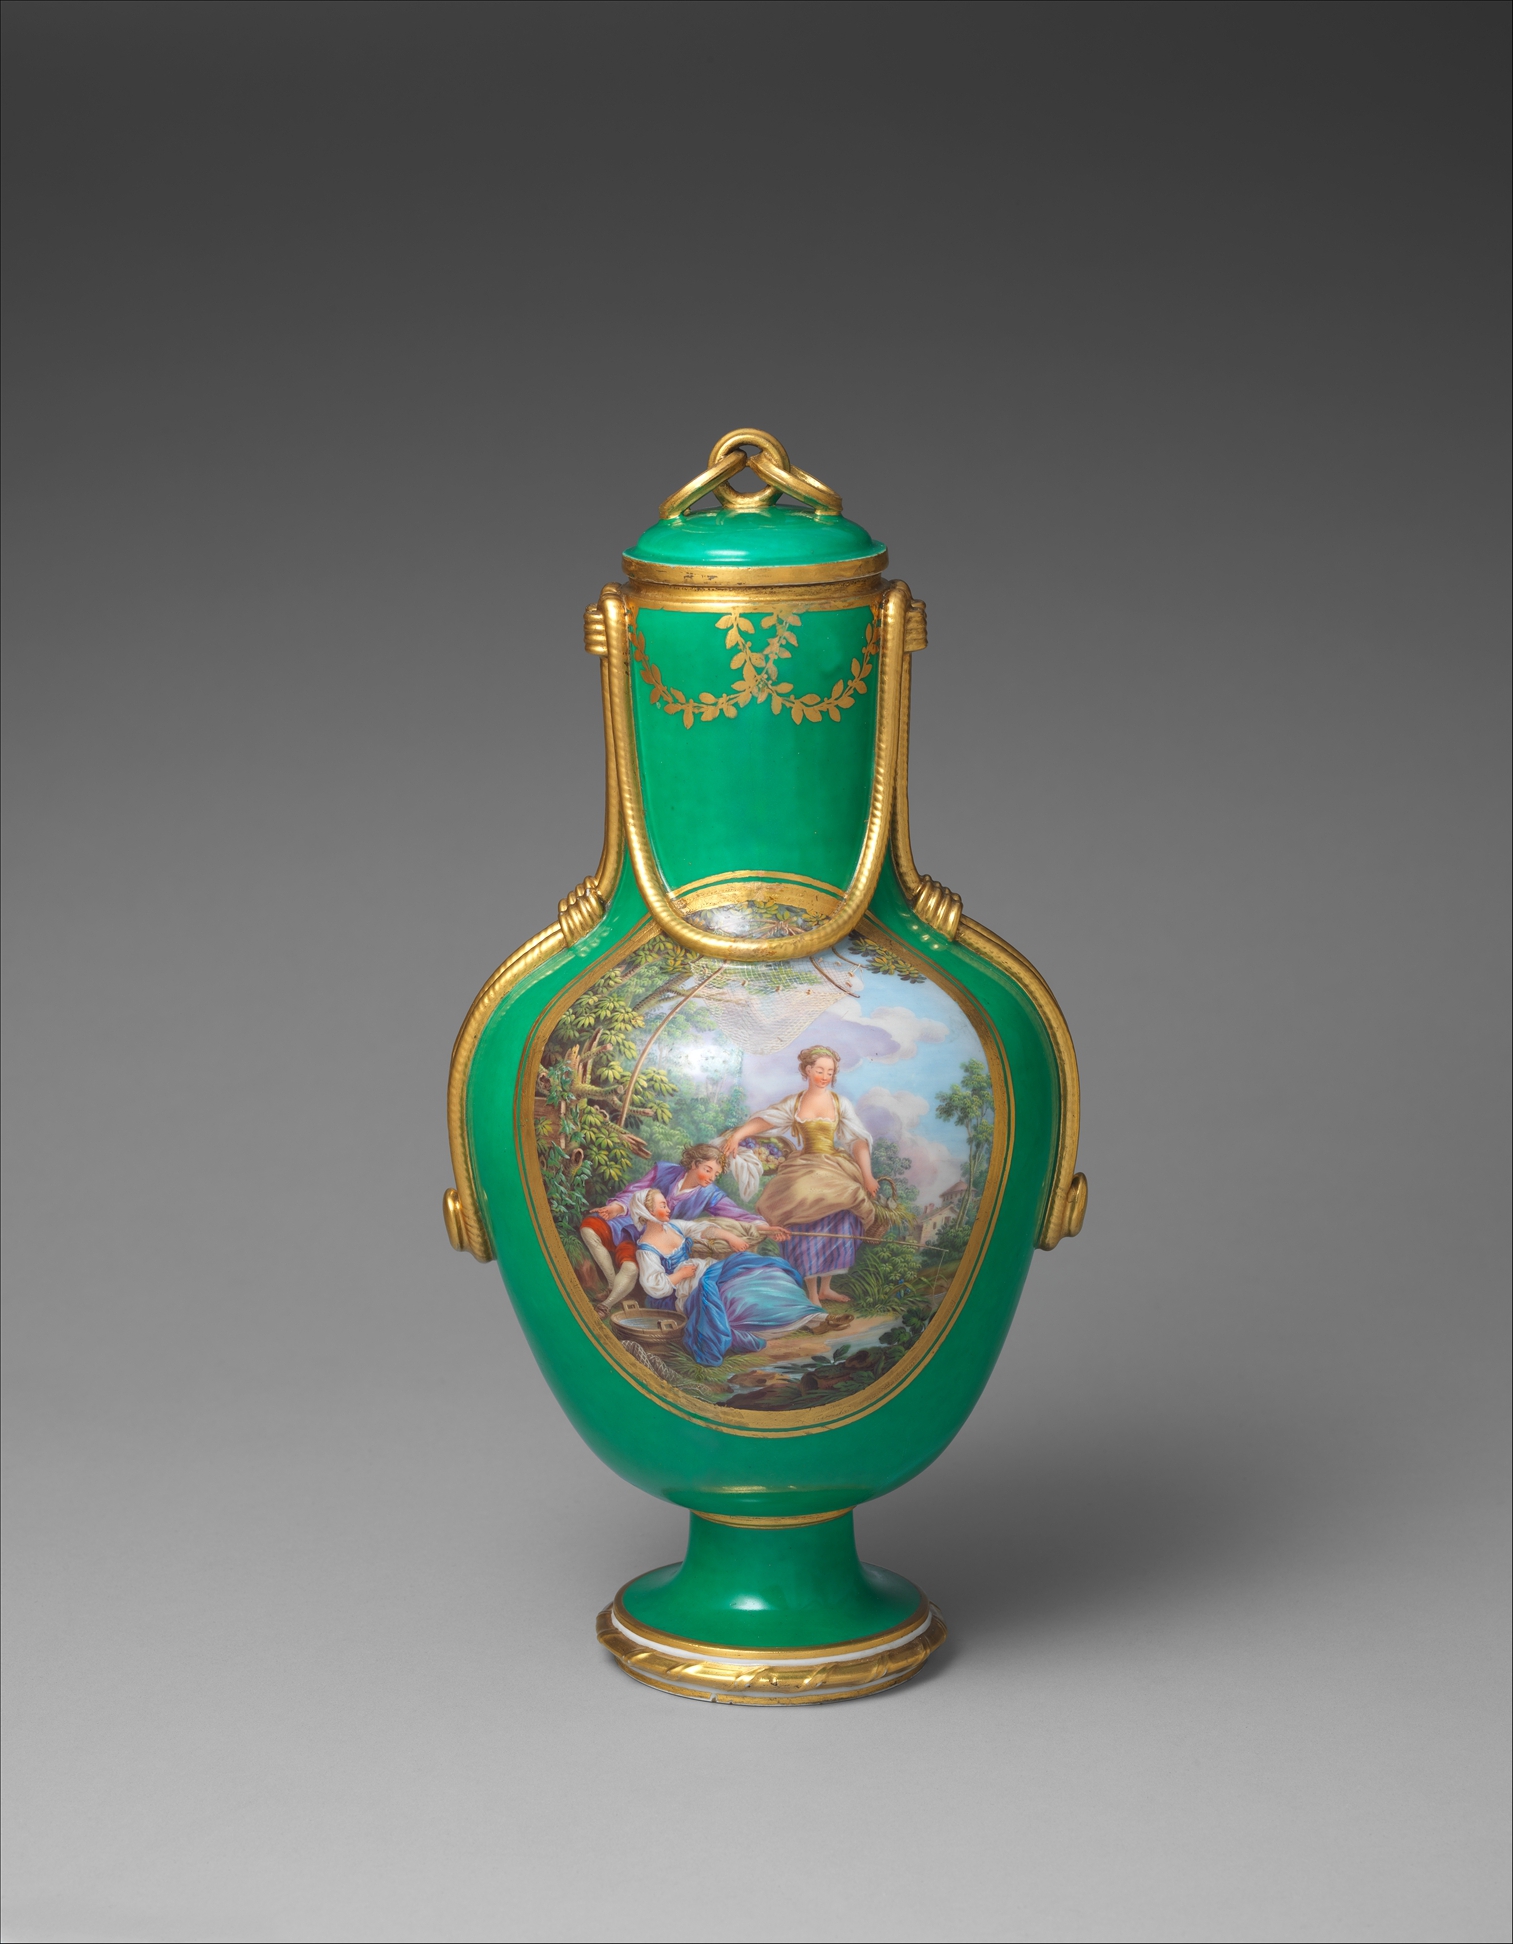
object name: vase with cover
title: Vase with cover (vase à flacon) (one of a pair)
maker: sèvres manufactory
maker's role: manufactory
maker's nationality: french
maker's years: 1740-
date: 1772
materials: soft paste porcelain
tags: women,trees